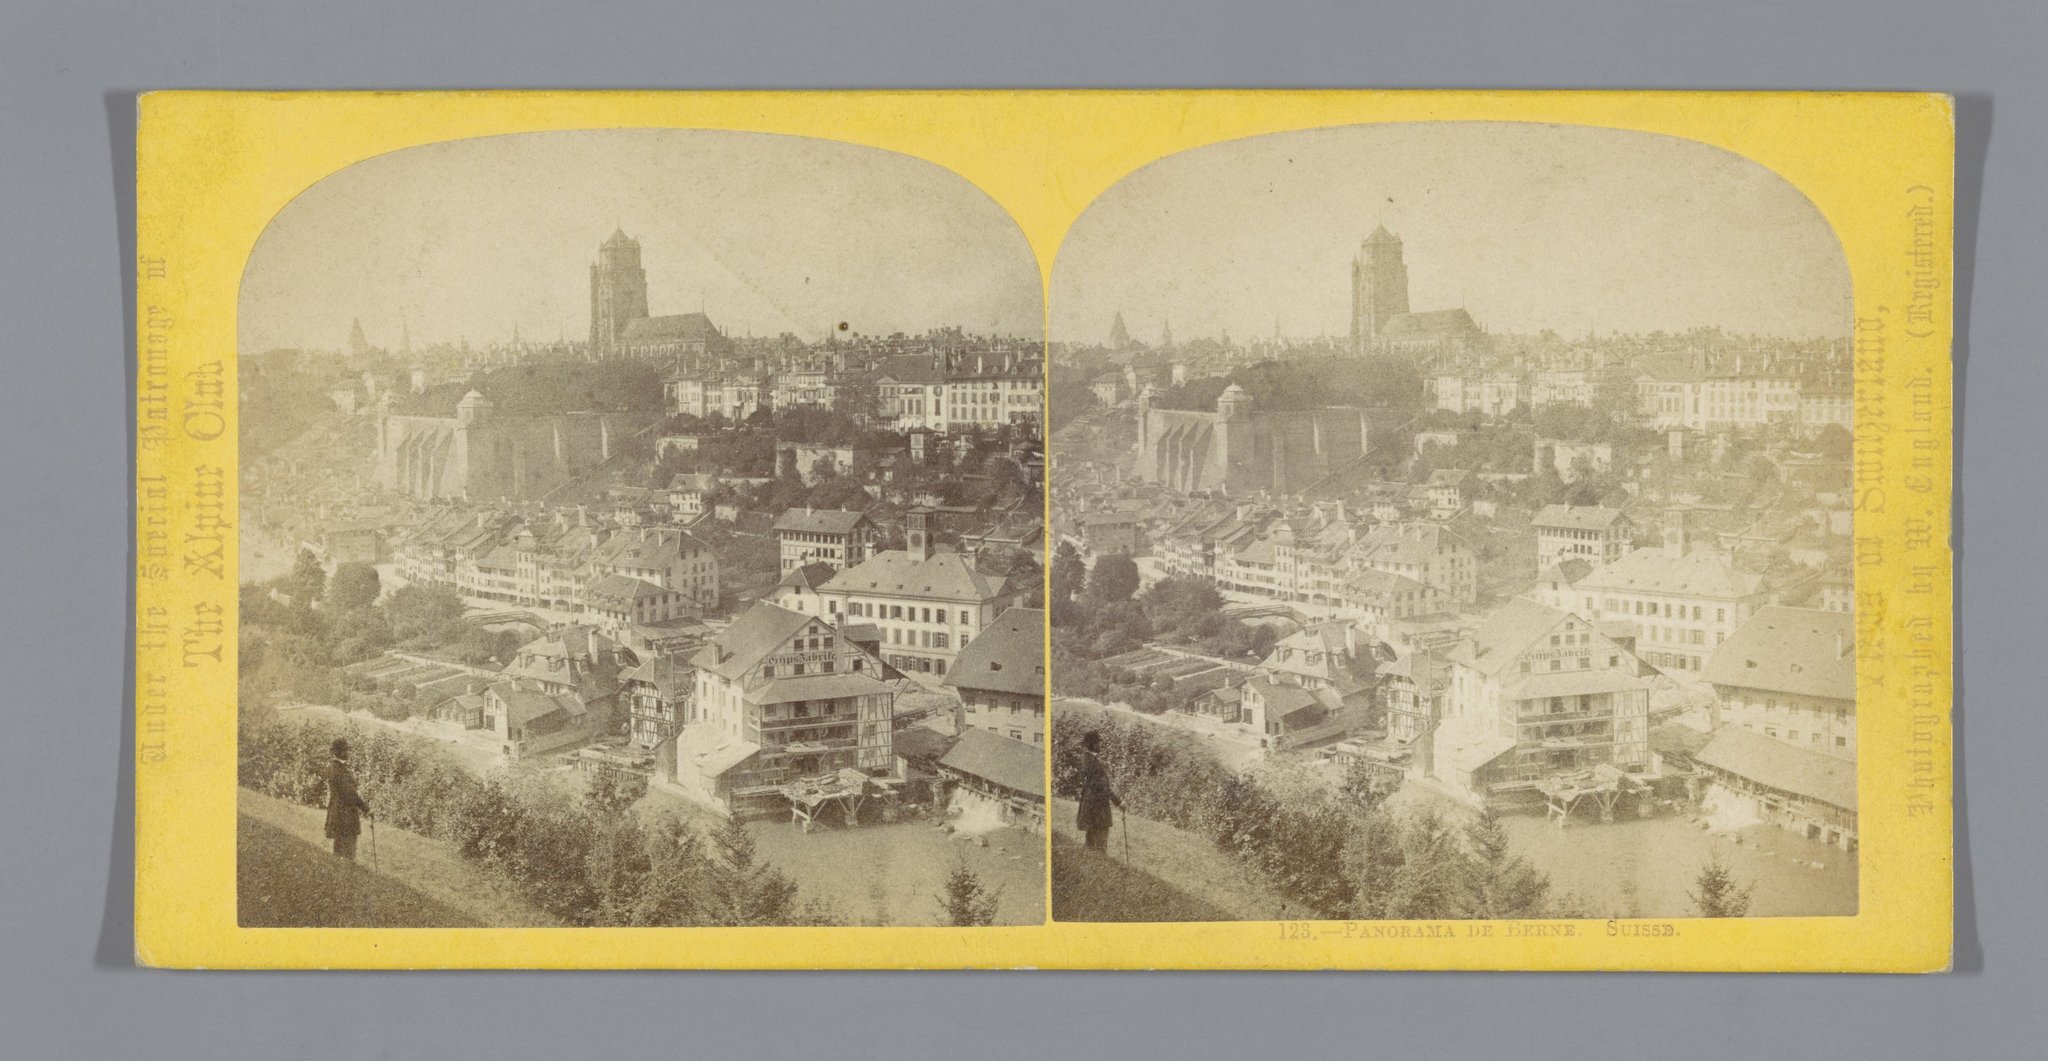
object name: stereograph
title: Panorama de Berne. Suisse.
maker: william england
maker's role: fotograaf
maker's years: 1816-1896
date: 1850-1880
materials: cardboard, photographic support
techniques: albumen print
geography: bern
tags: city-view in general; 'veduta'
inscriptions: number: ‘123.’, inscription: ‘Views of Switzerland, photographed by W. England. (Registered) Under the Special Patronage of the Alpine Club.’